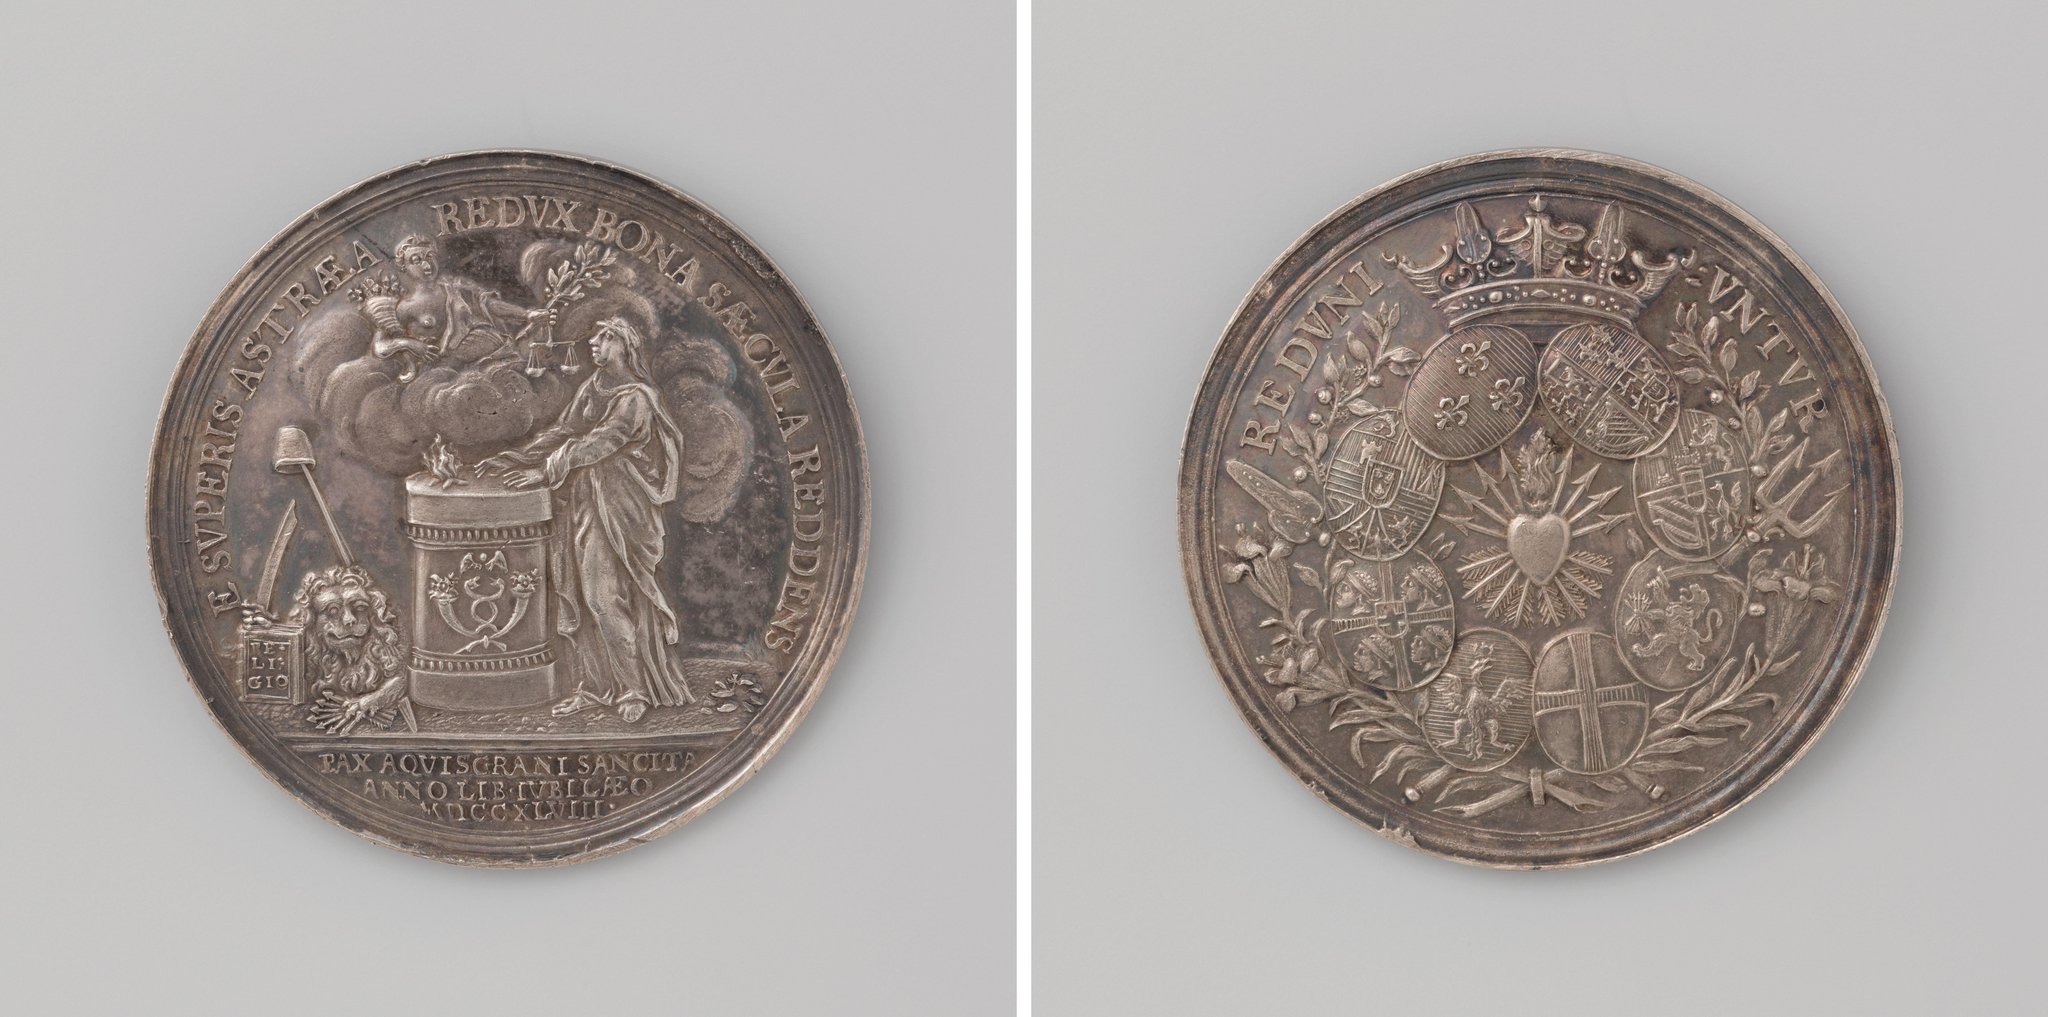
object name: history medal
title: Vrede te Aken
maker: martinus holtzhey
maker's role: medailleur, muntmaker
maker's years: 1697-1764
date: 1748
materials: silver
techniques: striking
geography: amsterdam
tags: aken, vrede van aken (1748)